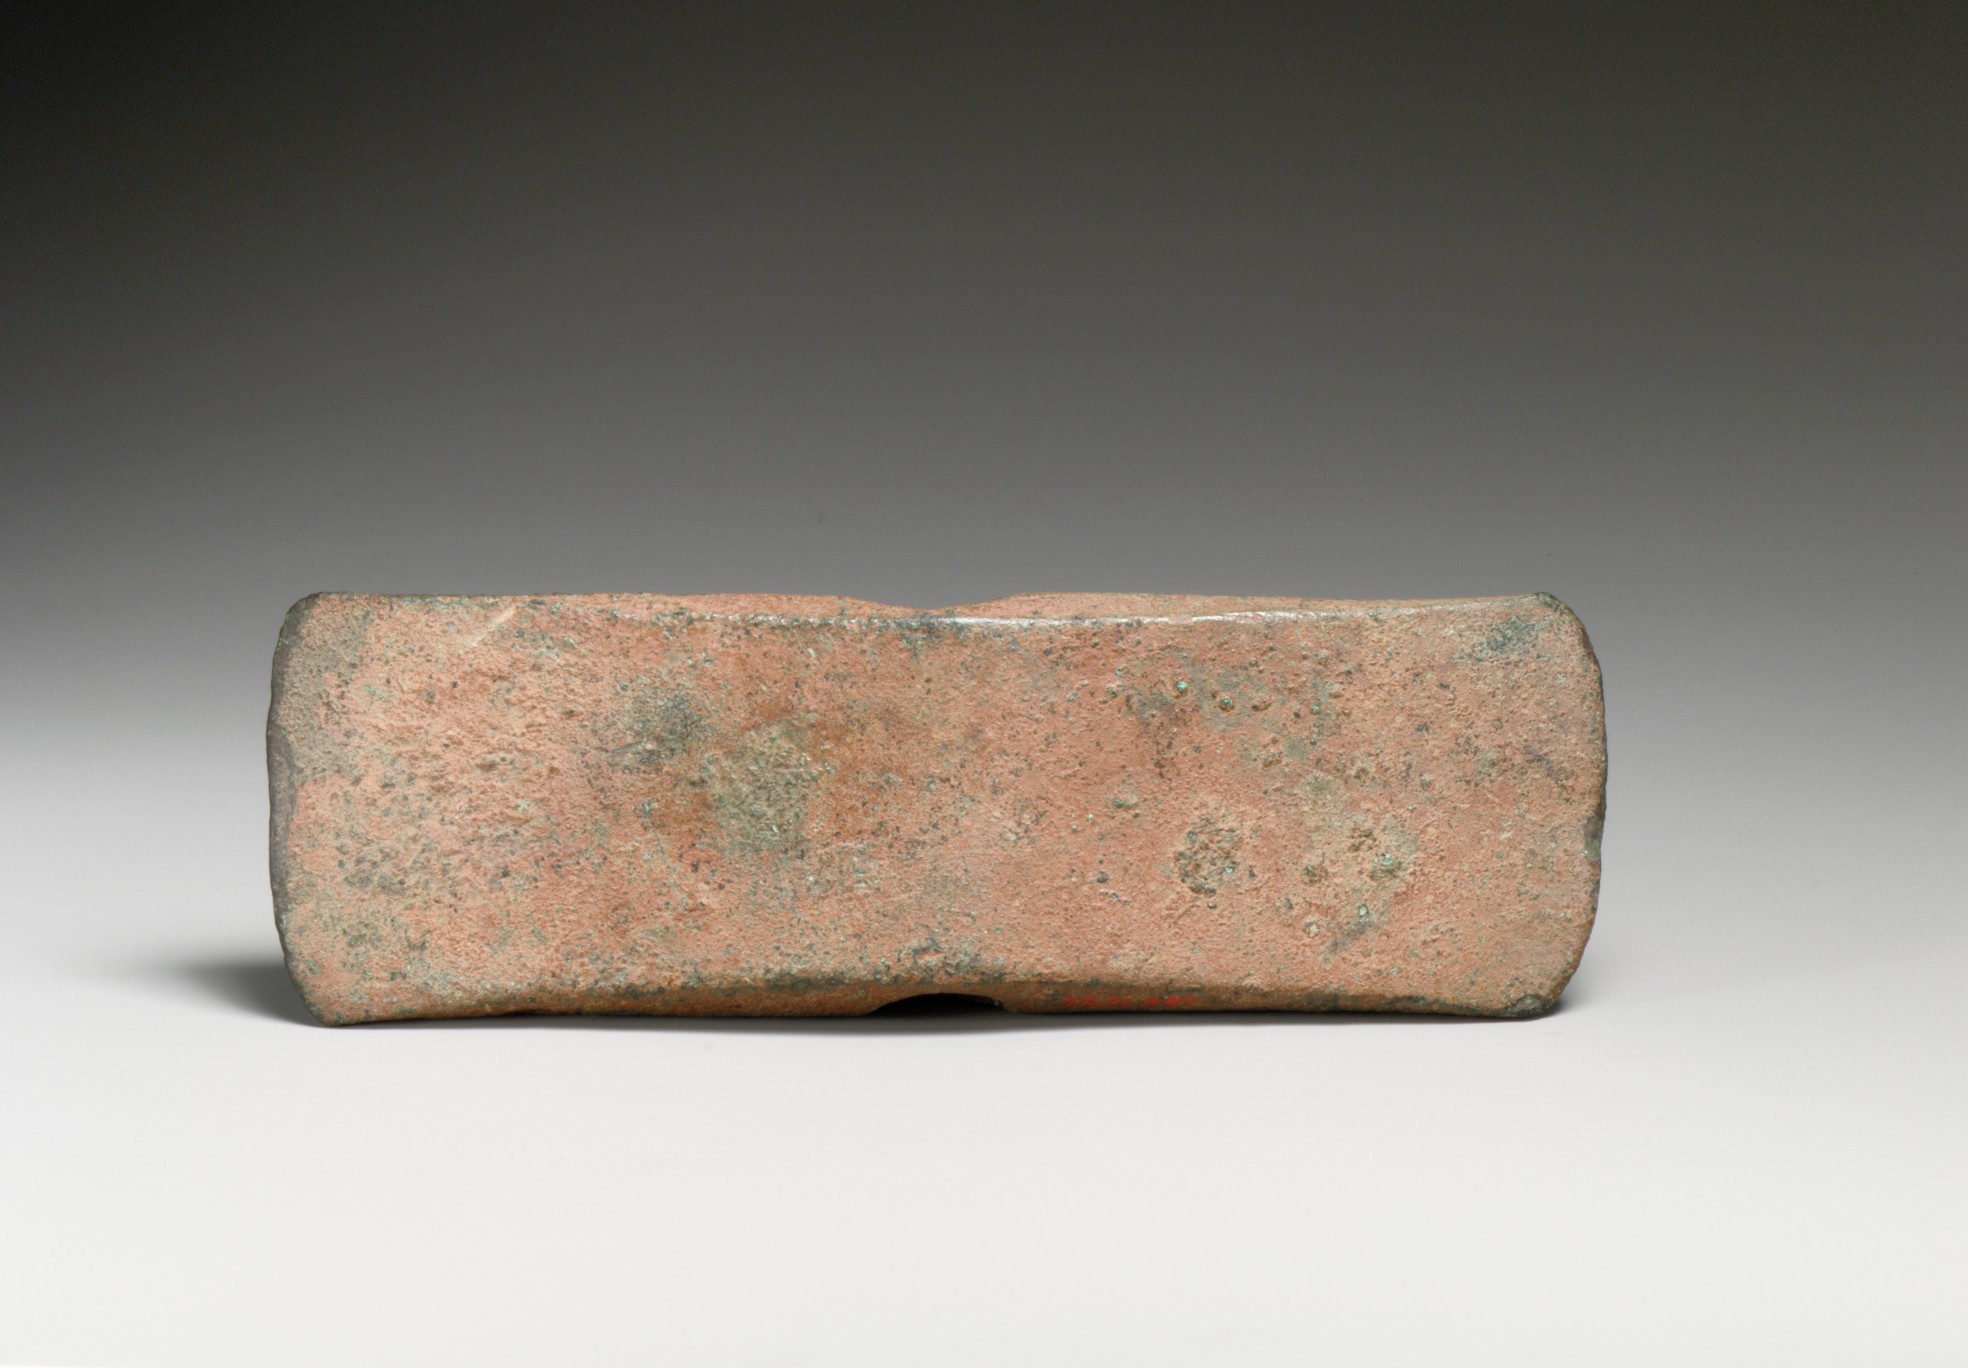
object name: axehead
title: Bronze double axe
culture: minoan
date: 1600-1050 BCE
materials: bronze